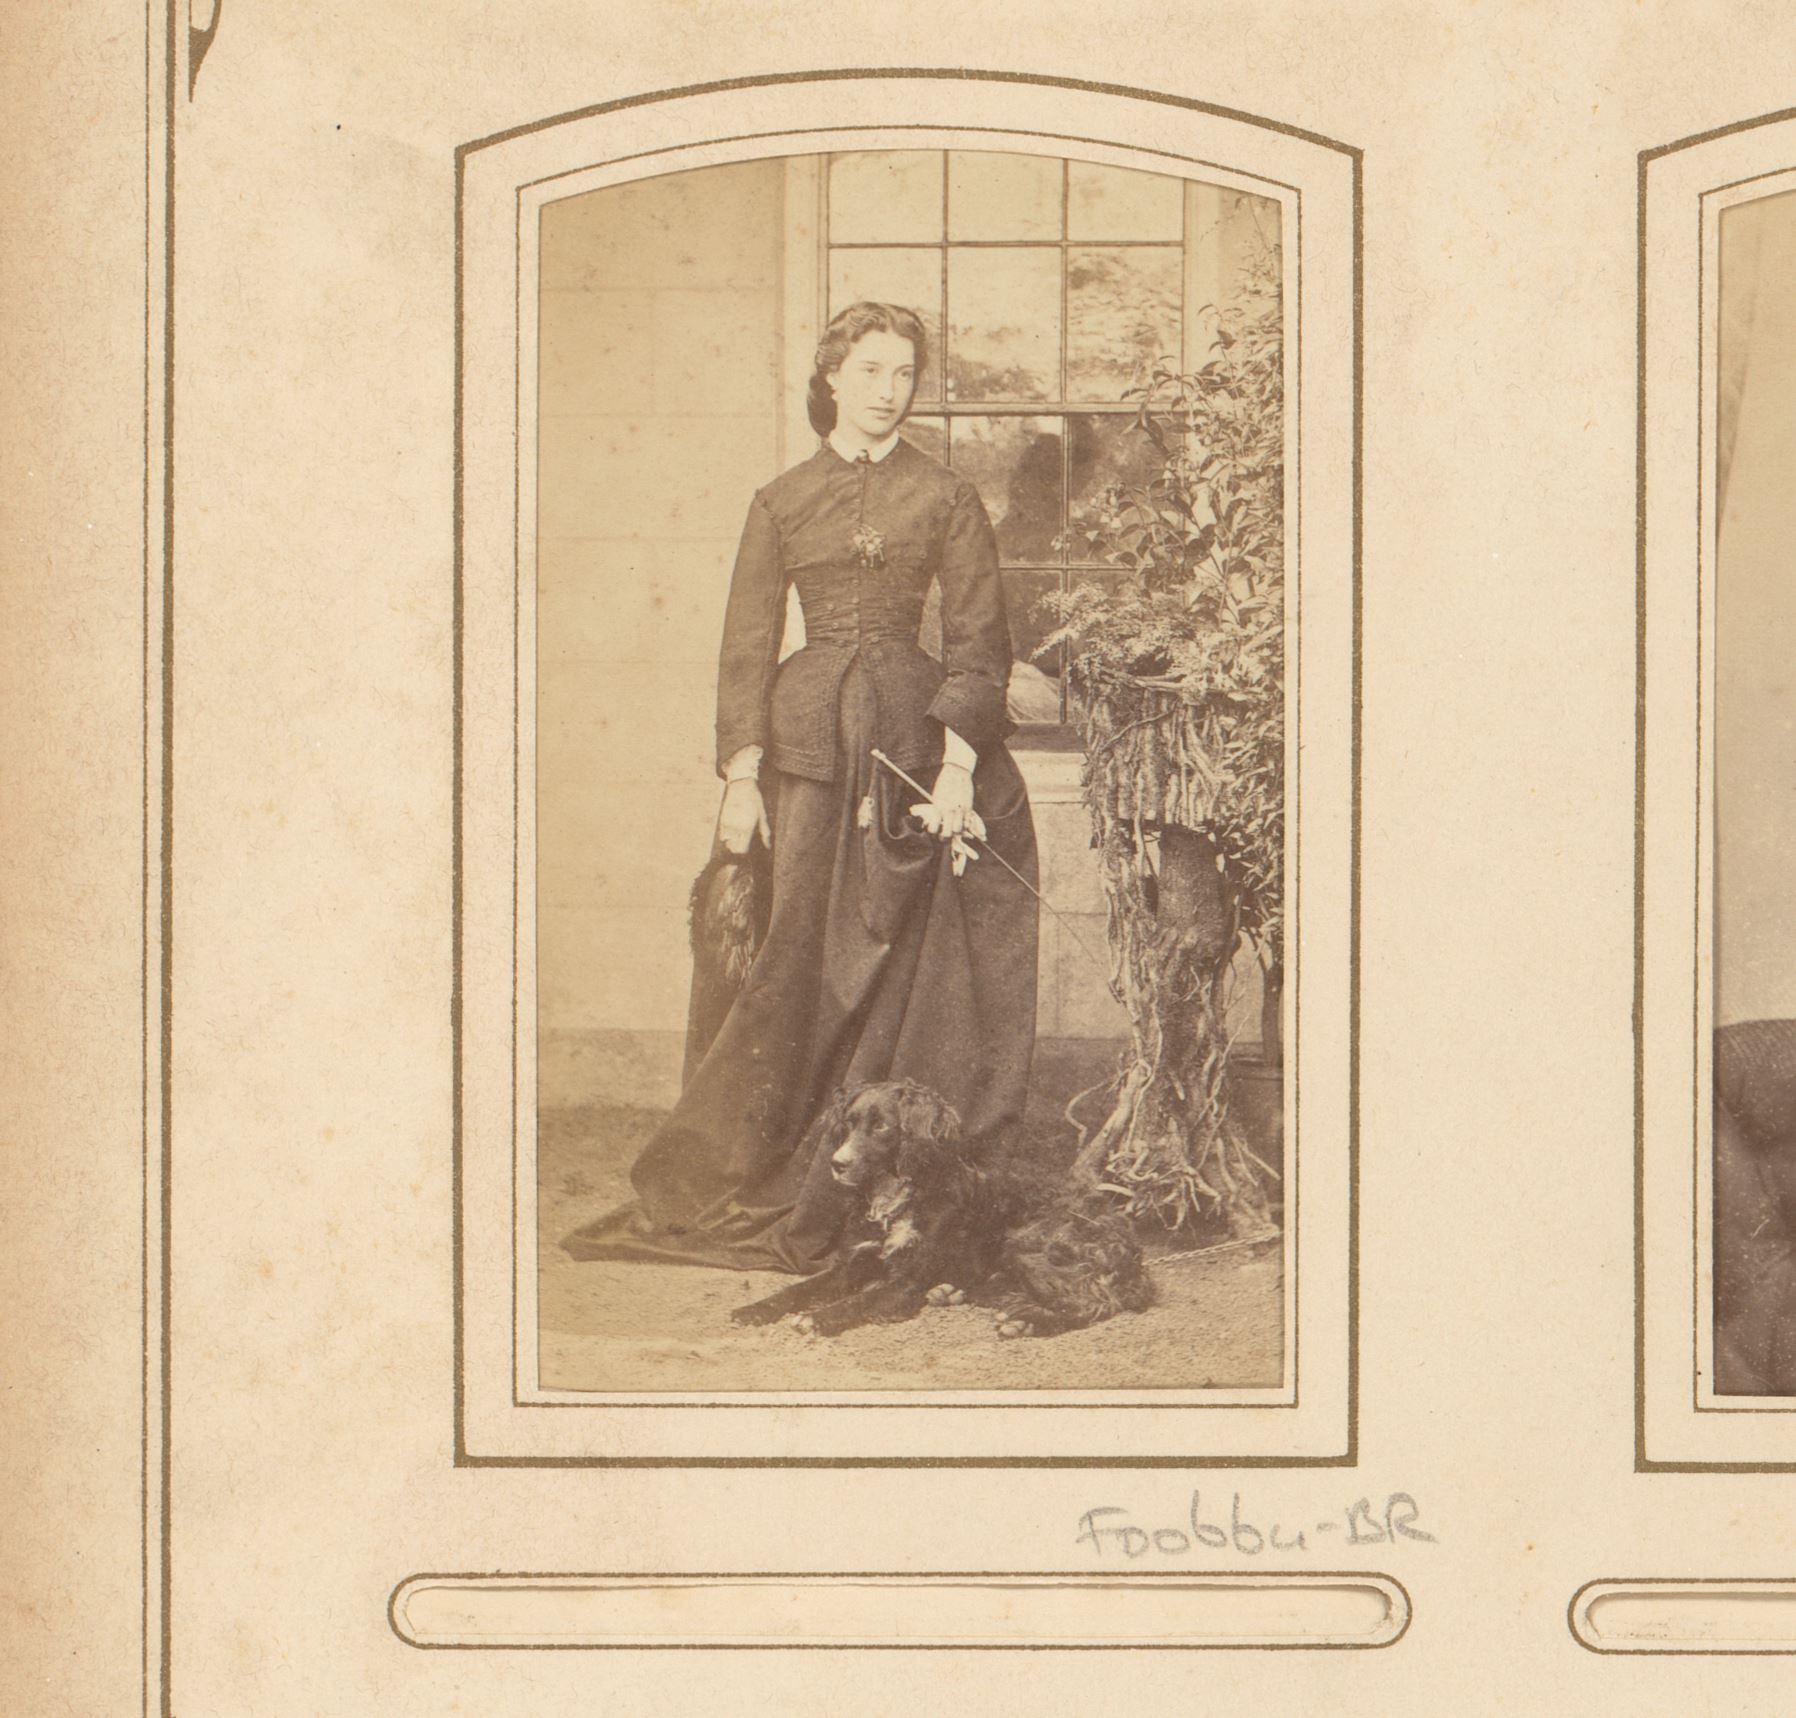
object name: album leaf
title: Portret van een vrouw met attributen en hond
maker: c.b. button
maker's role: fotograaf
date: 1860-1880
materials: cardboard, photographic support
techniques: albumen print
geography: guernsey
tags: historical persons, dog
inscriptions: inscription: ‘C.B. Button/ Guernsey Photographic Studio, 10, Grande Road, Guernsey’